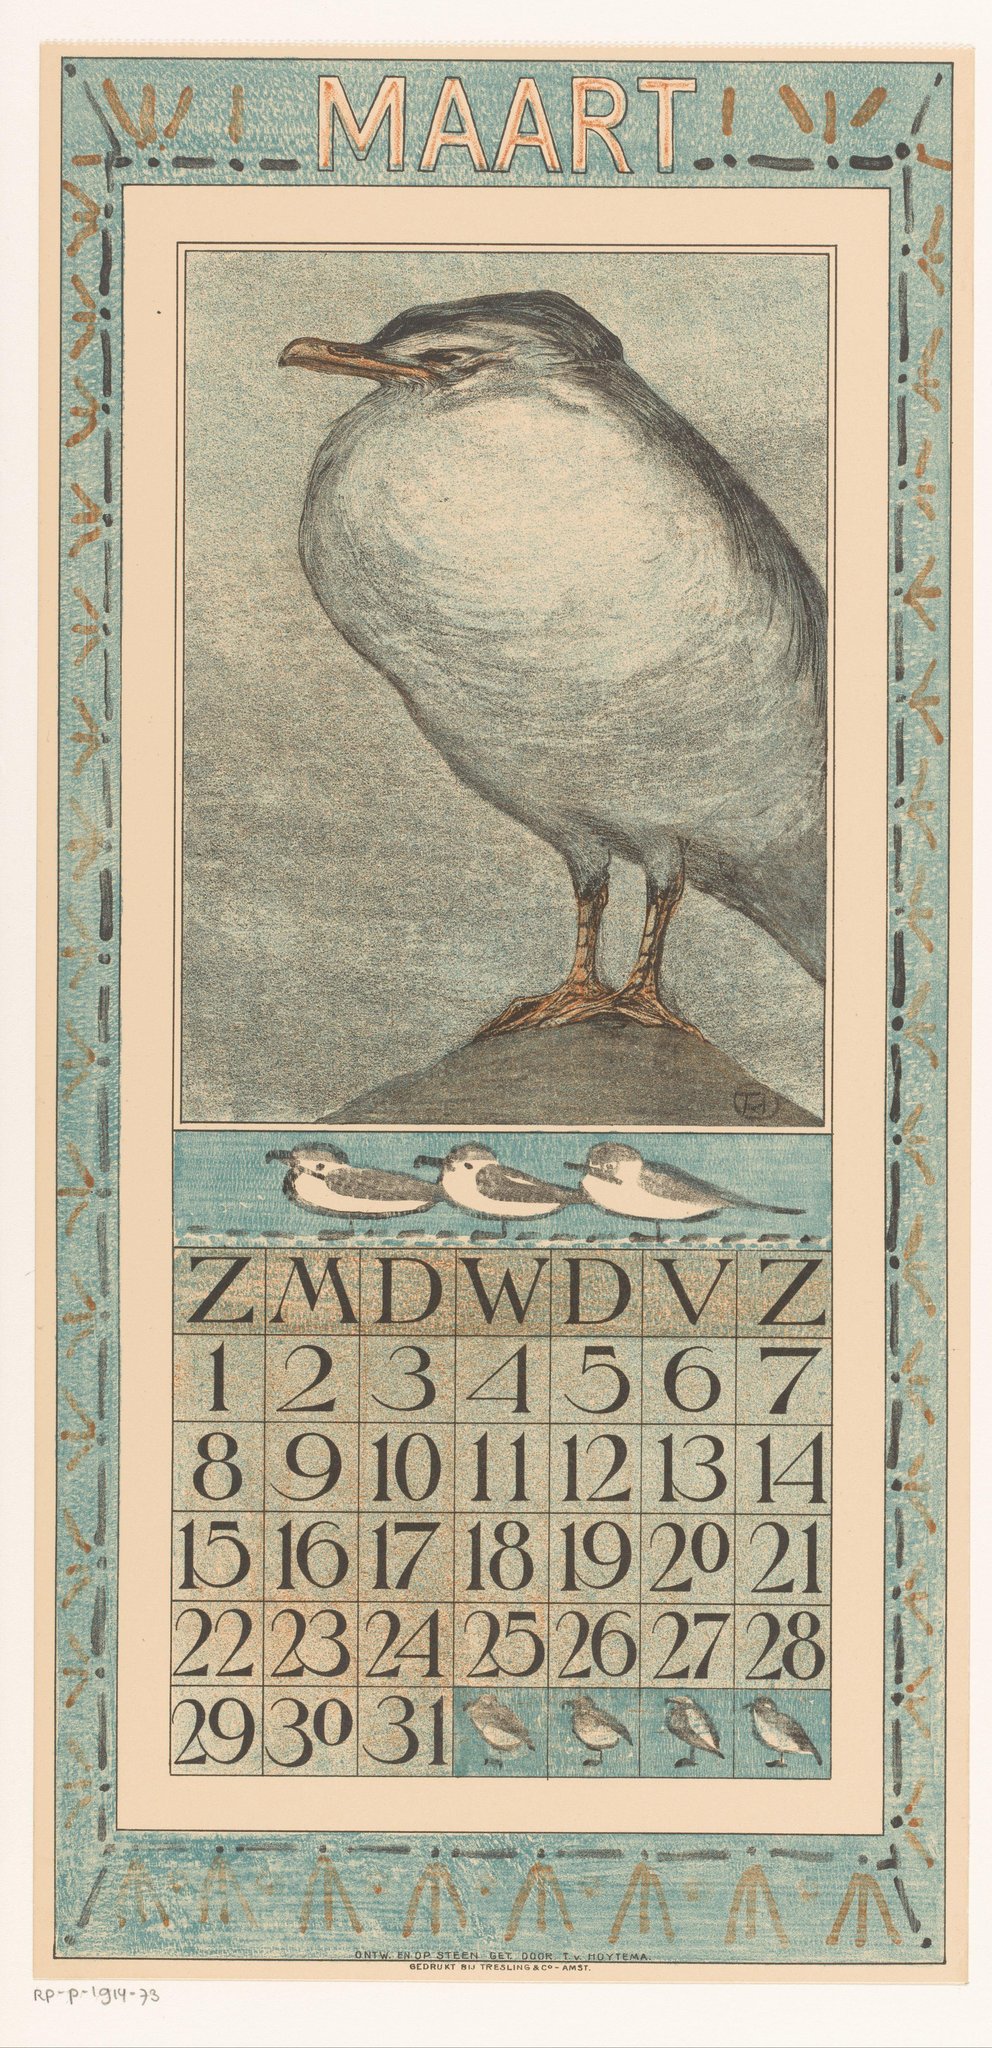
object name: calendar leaf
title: Kalender 1908 12 lithografien door Th. v. Hoytema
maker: theo van hoytema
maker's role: draughtsman, painter, print maker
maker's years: 1863-1917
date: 1907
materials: paper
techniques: lithograph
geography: the hague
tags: shore-birds and wading-birds, april ~ other concepts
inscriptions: collector's mark: Lugt 2228